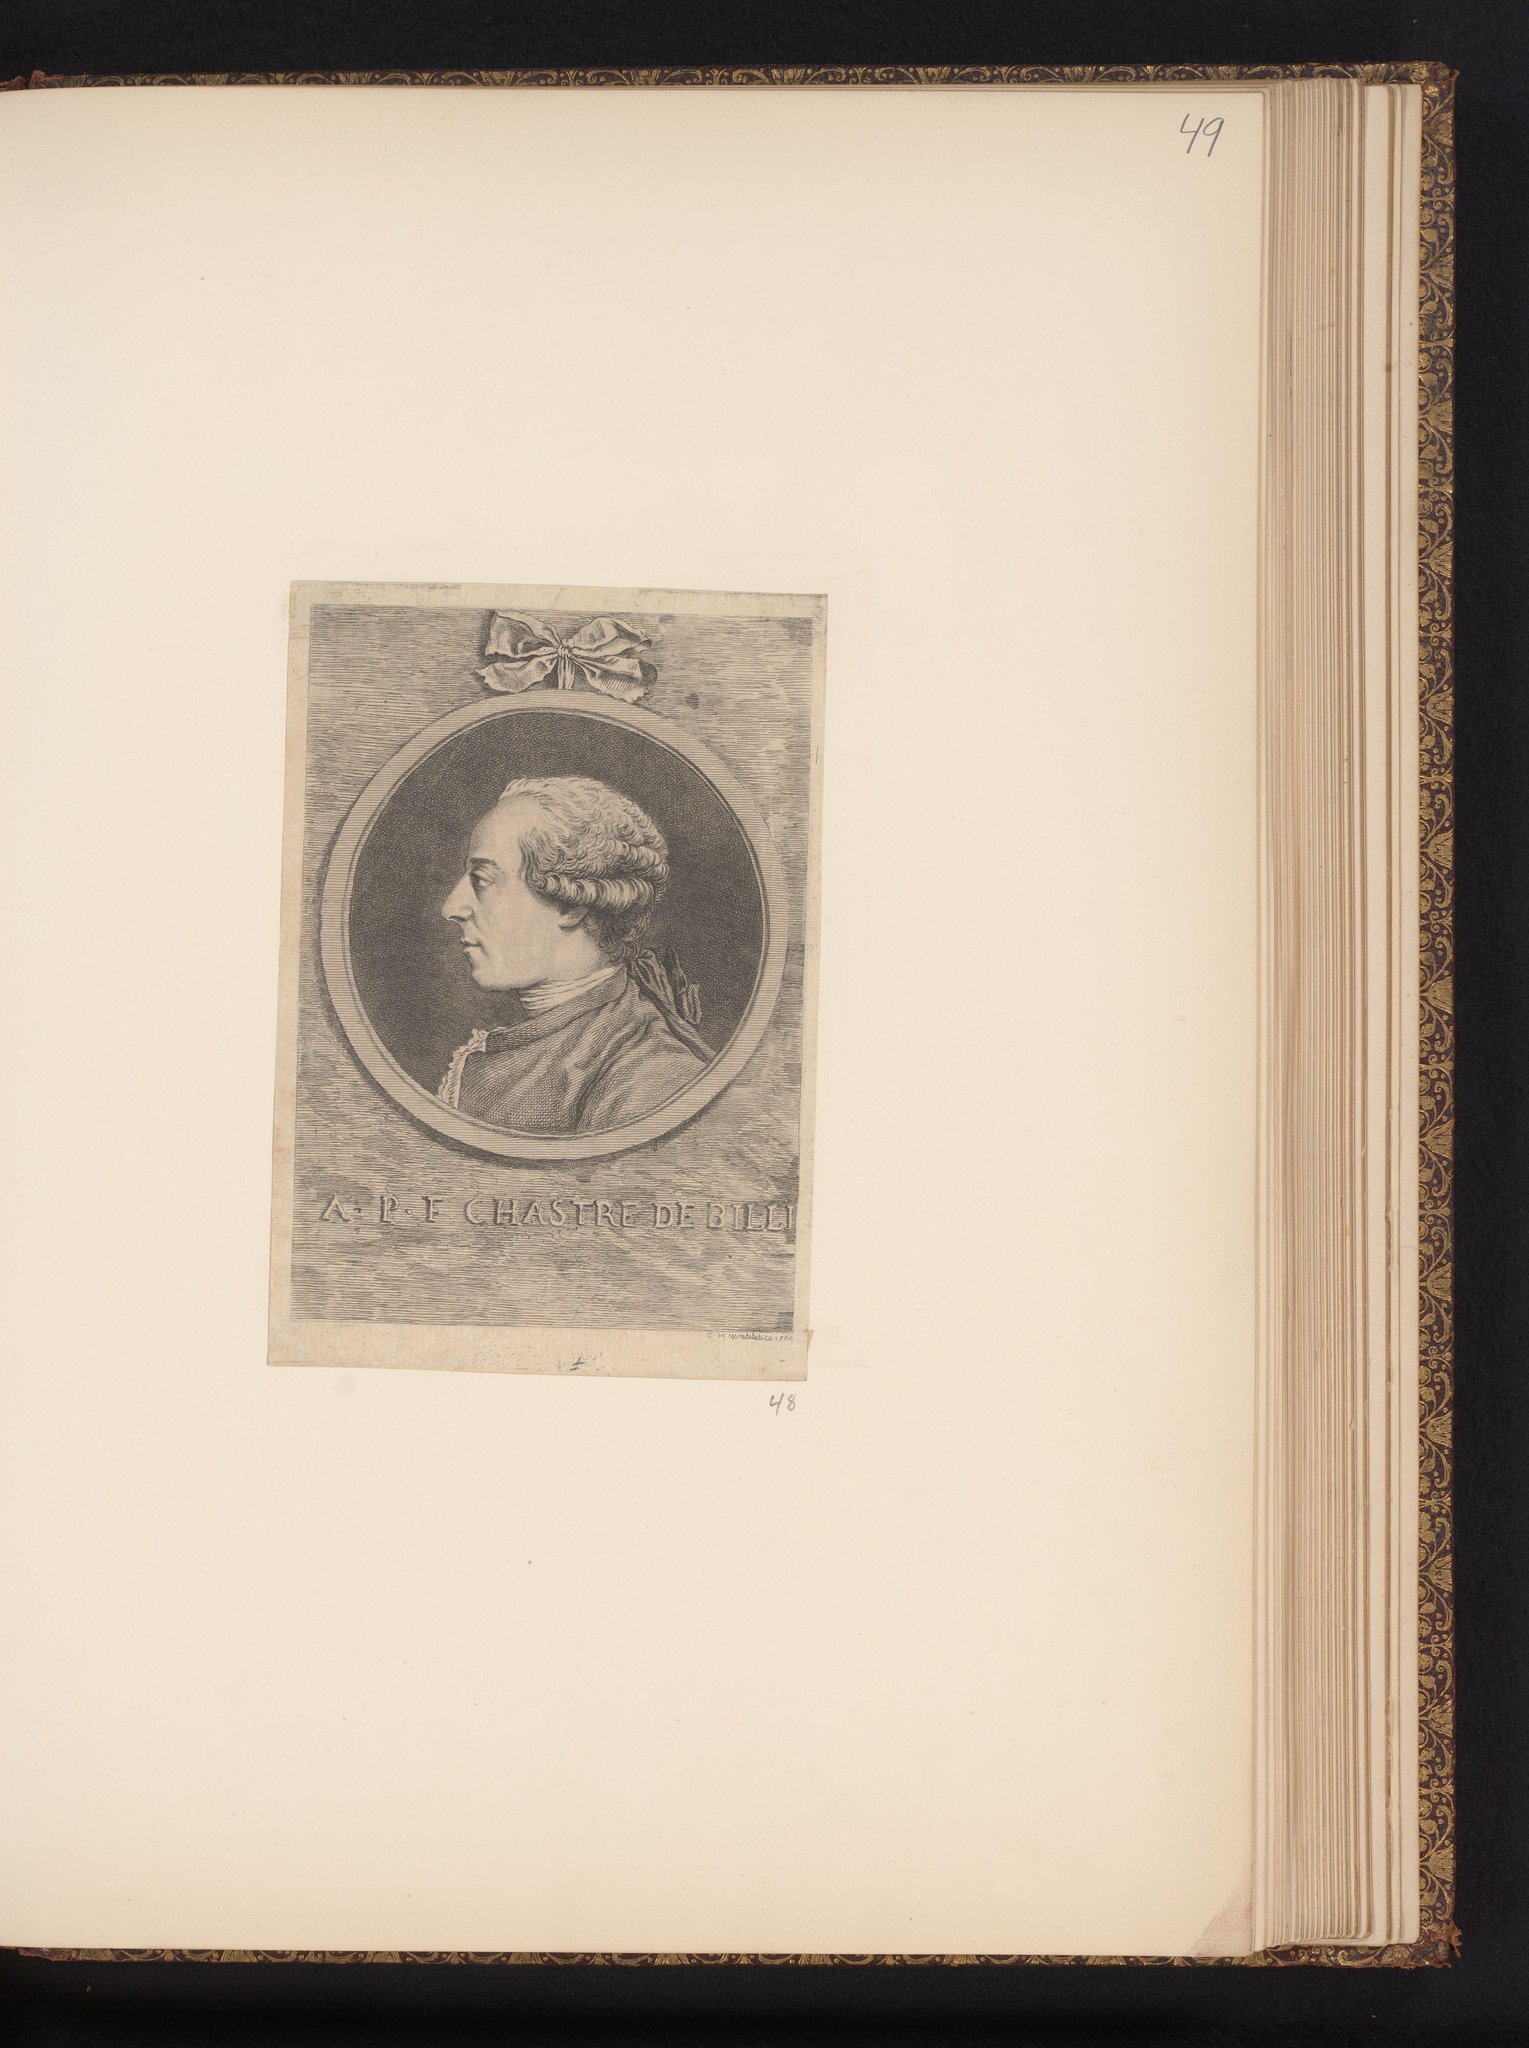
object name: print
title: Portret van Armand Pierre François de Chastre de Billy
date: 1760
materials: paper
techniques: engraving, etching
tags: historical persons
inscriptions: date